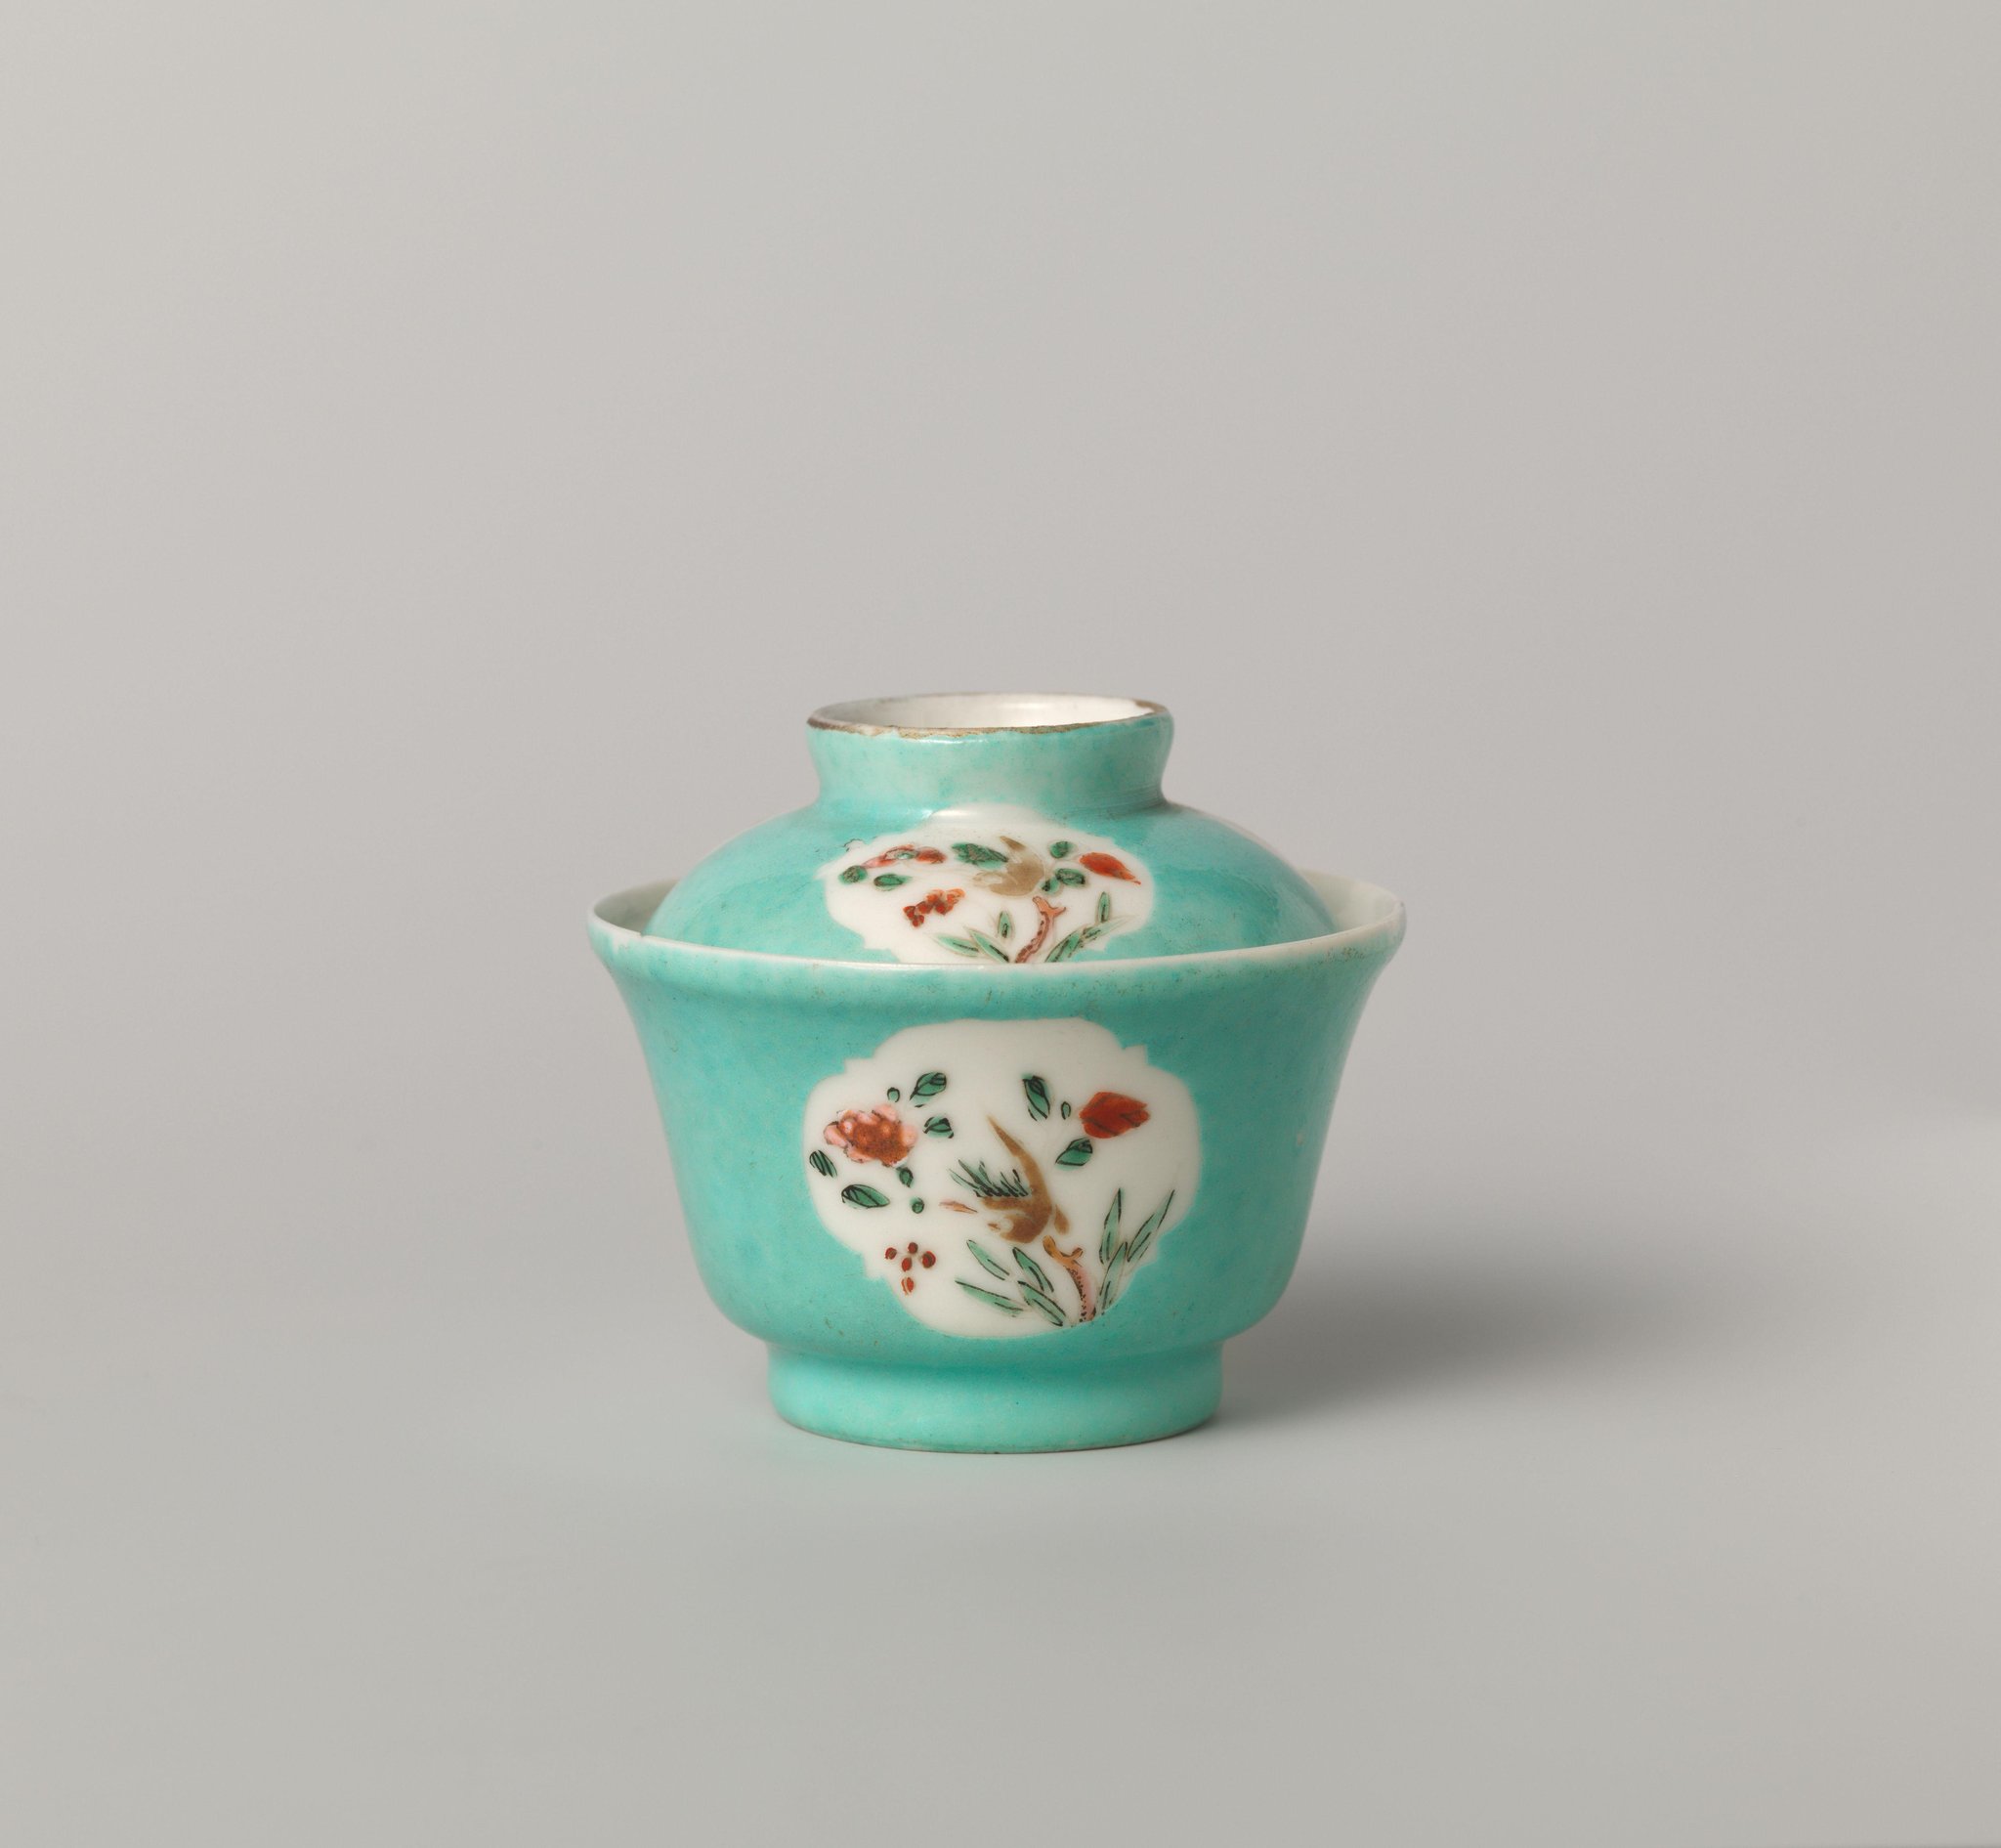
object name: lid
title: Bell-shaped covered cup with flowering plants in shaped panels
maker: Anonymous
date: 1760-1780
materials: glaze, gold, paint, porcelain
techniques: firing, gilding, turning, vitrification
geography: china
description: Deksel van klokvormige kop en schotel van porselein, bedekt met een turquoise glazuur en berschilderd in blauw, rood, roze, groen, zwart en goud. Bedekt met een turquoise glazuur met hierin uitgespaard in het centrum een geschulpt medaillon met plant, daaromheen drie uitgespaarde cartouches met bloeiende planten en een vogel op een tak. Famille rose.